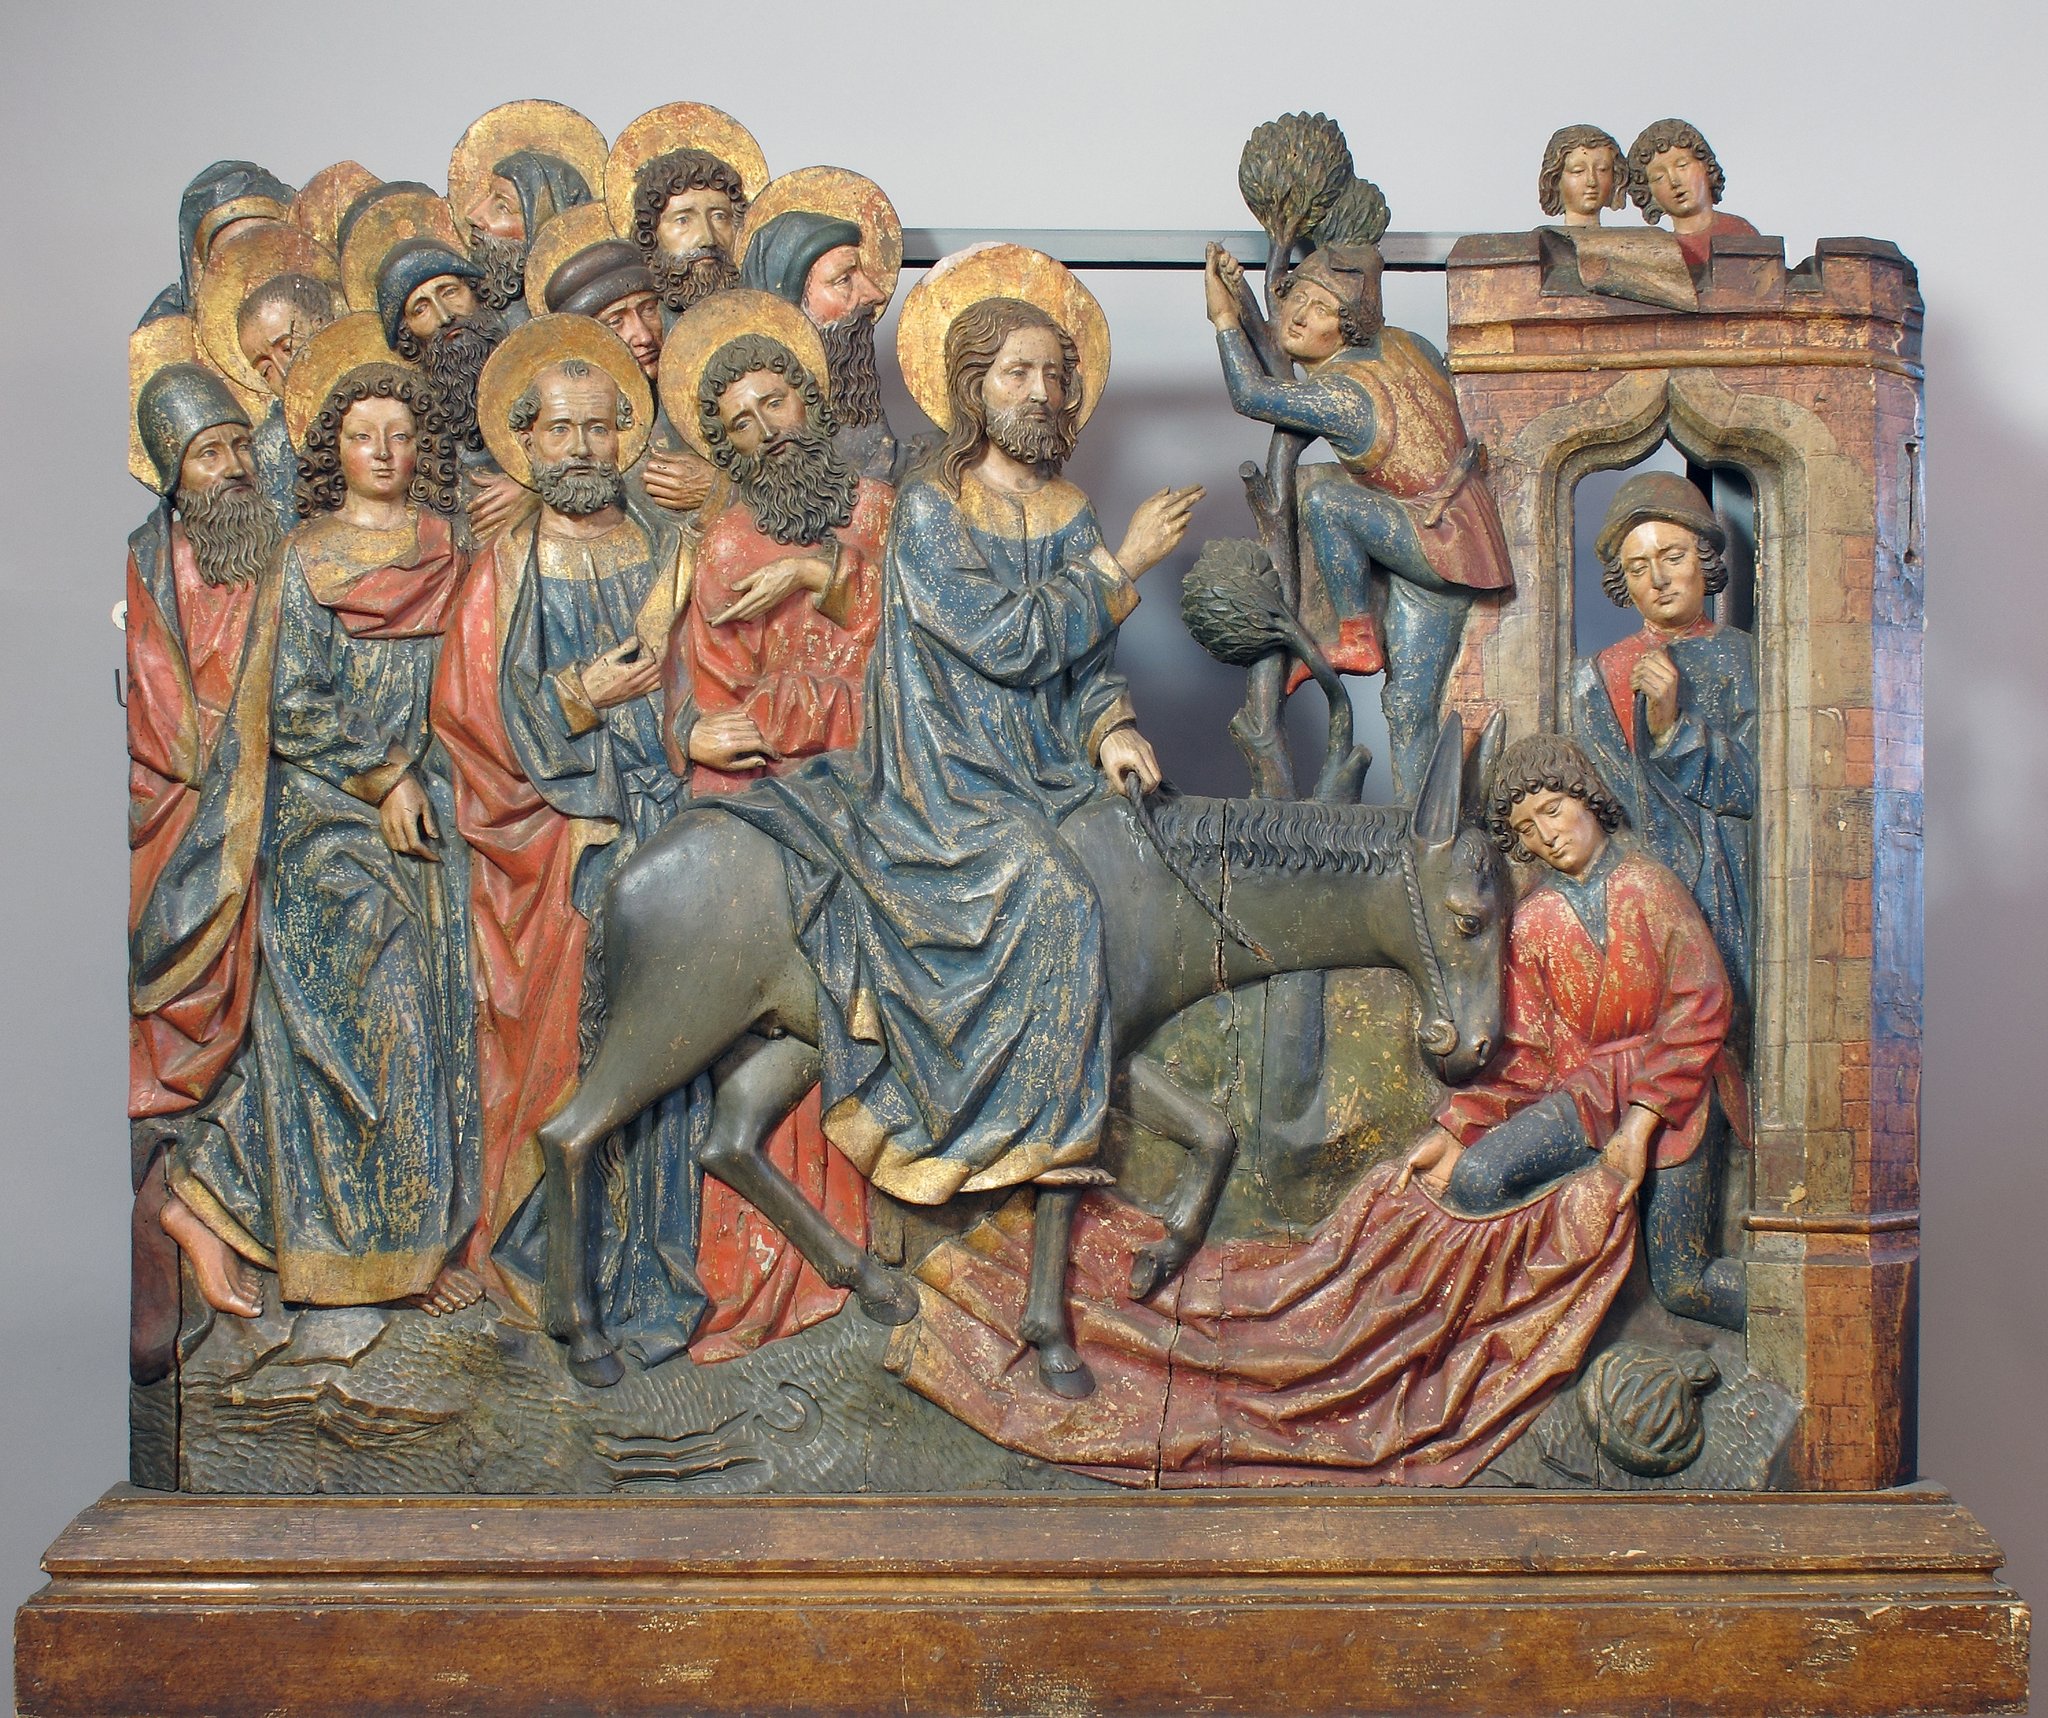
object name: relief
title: Entry into Jerusalem Relief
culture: german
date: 1401-1500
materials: gilt, paint, wood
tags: men,donkeys,apostles,jesus